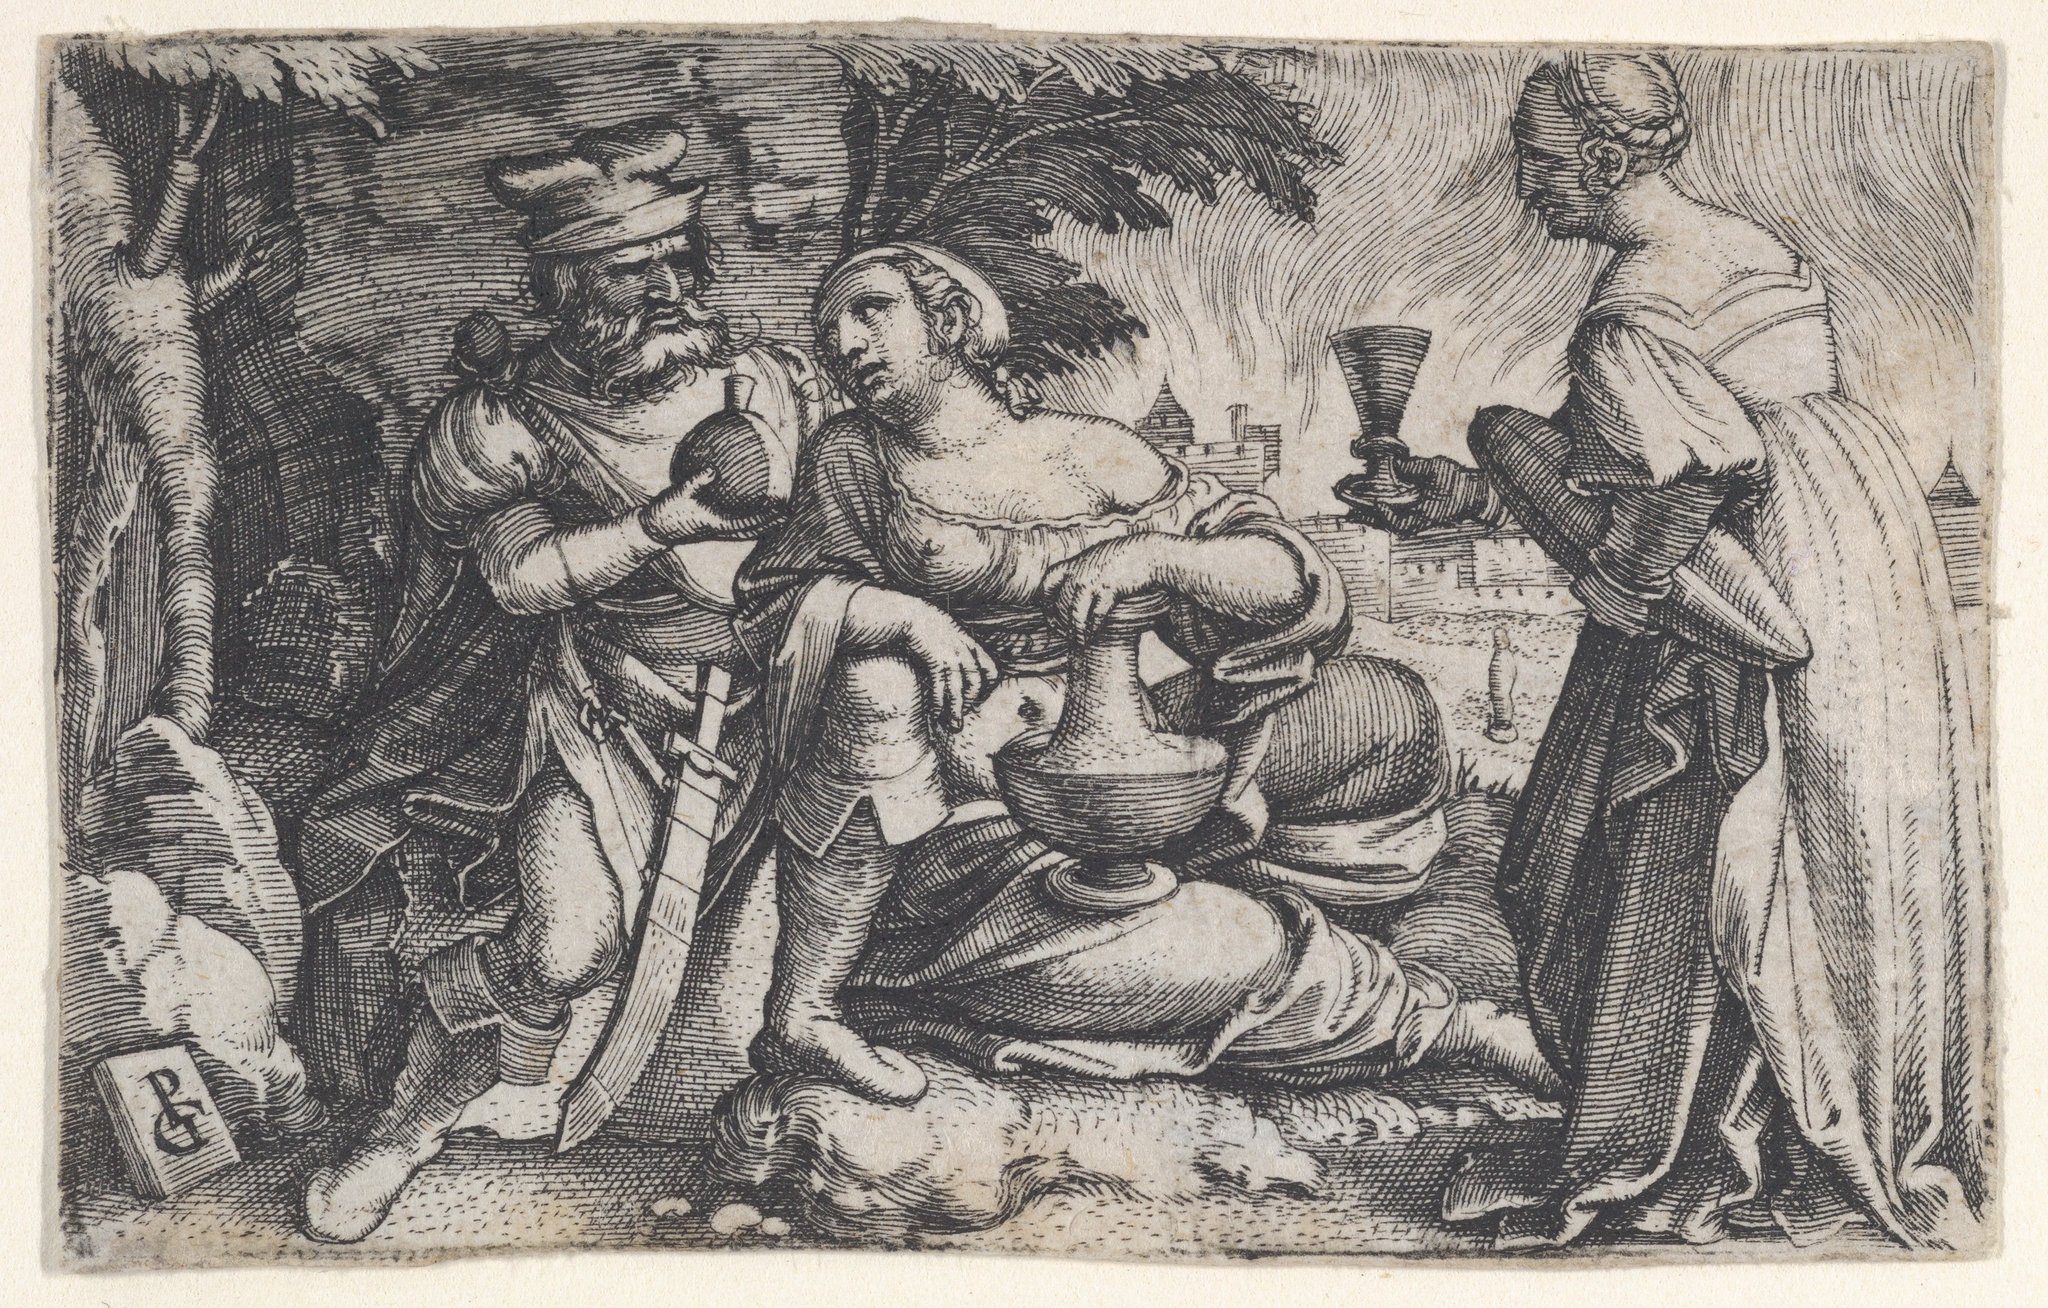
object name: print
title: Lot and His Daughters, from "Scenes from the Old Testament"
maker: georg pencz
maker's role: artist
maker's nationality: german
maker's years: 1500-1550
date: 1526-1536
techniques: engraving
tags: men,women